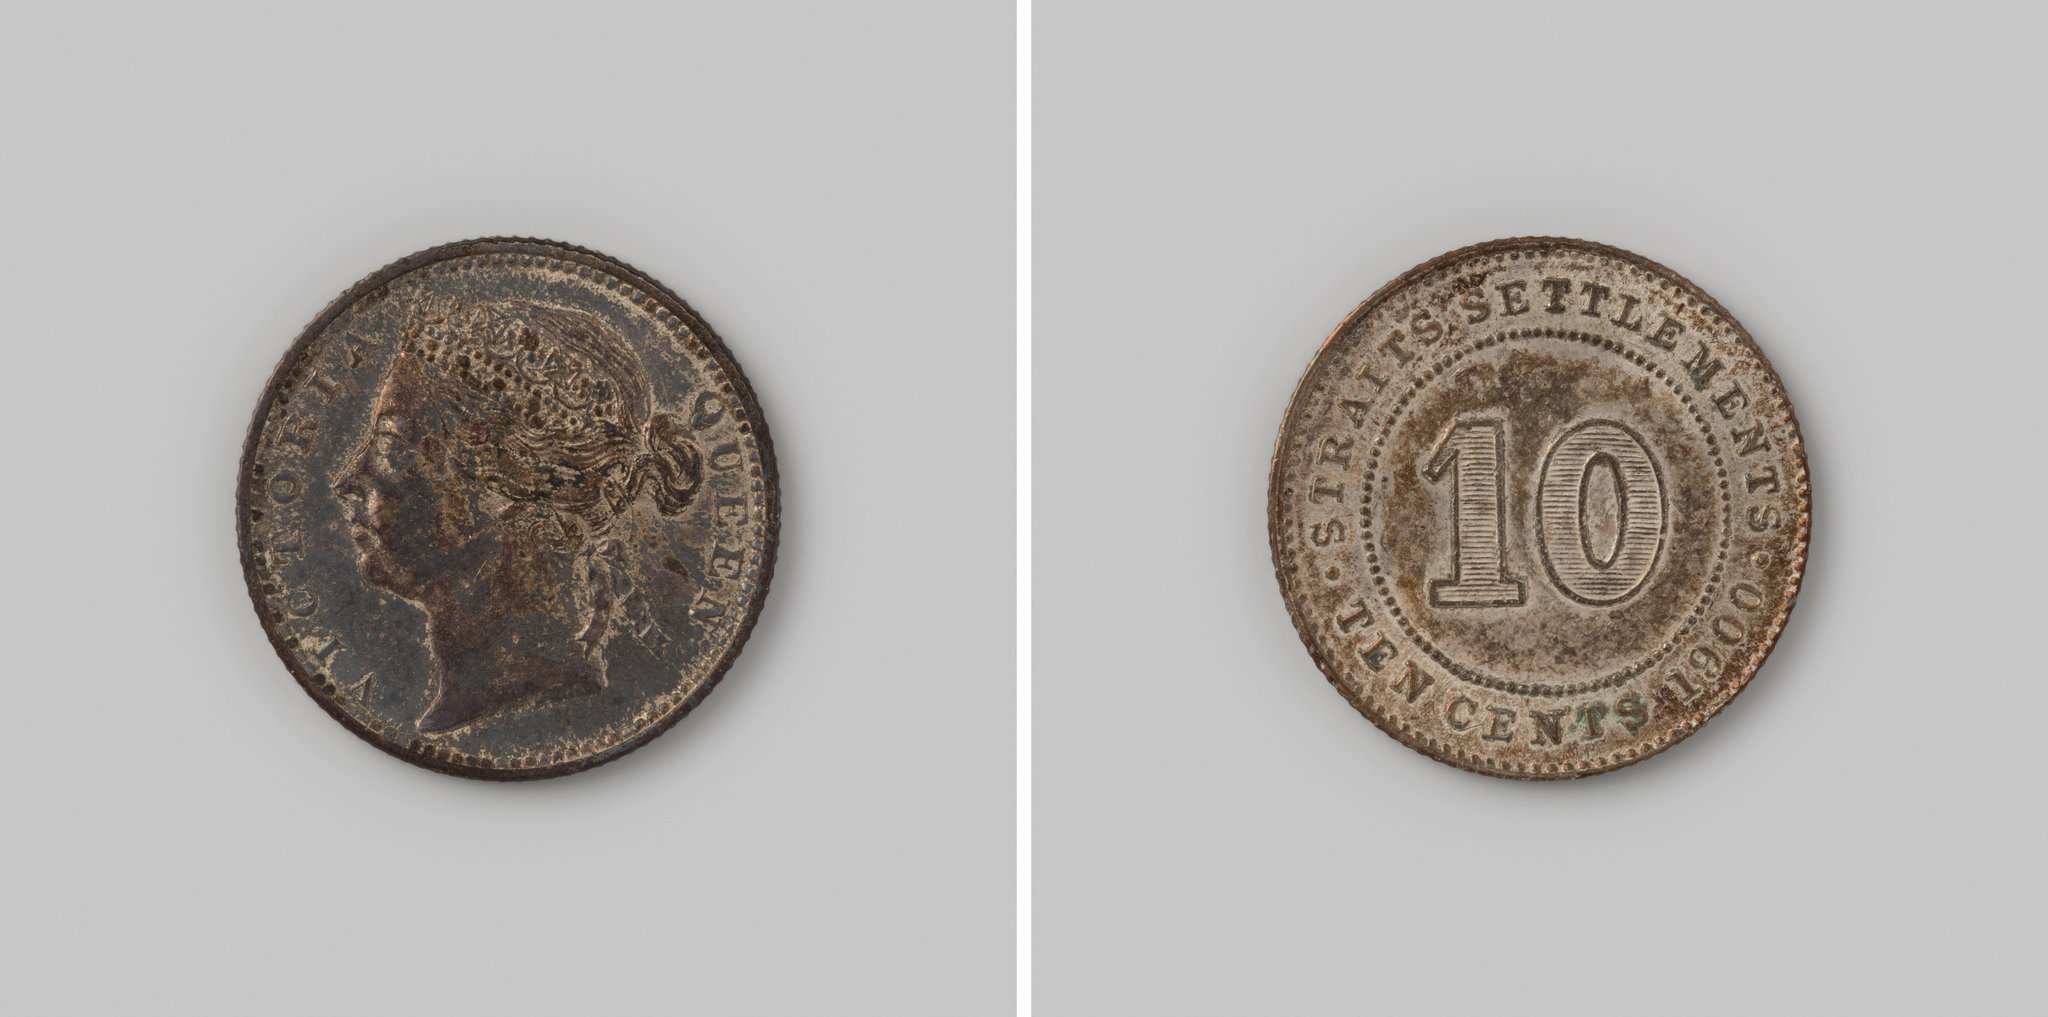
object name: coin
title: Straits Settlements, koningin Victoria, 10 cents, 1900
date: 1900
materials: silver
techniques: striking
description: Zilveren munt. Voorzijde: gekroond hoofd van koningin Victoria naar links. Keerzijde: binnen parelcirkel waarde-aanduiding: 10. In omschrift onderaan waarde-aanduiding: ten cents met rechts daarvan jaartal. Kartelrand.